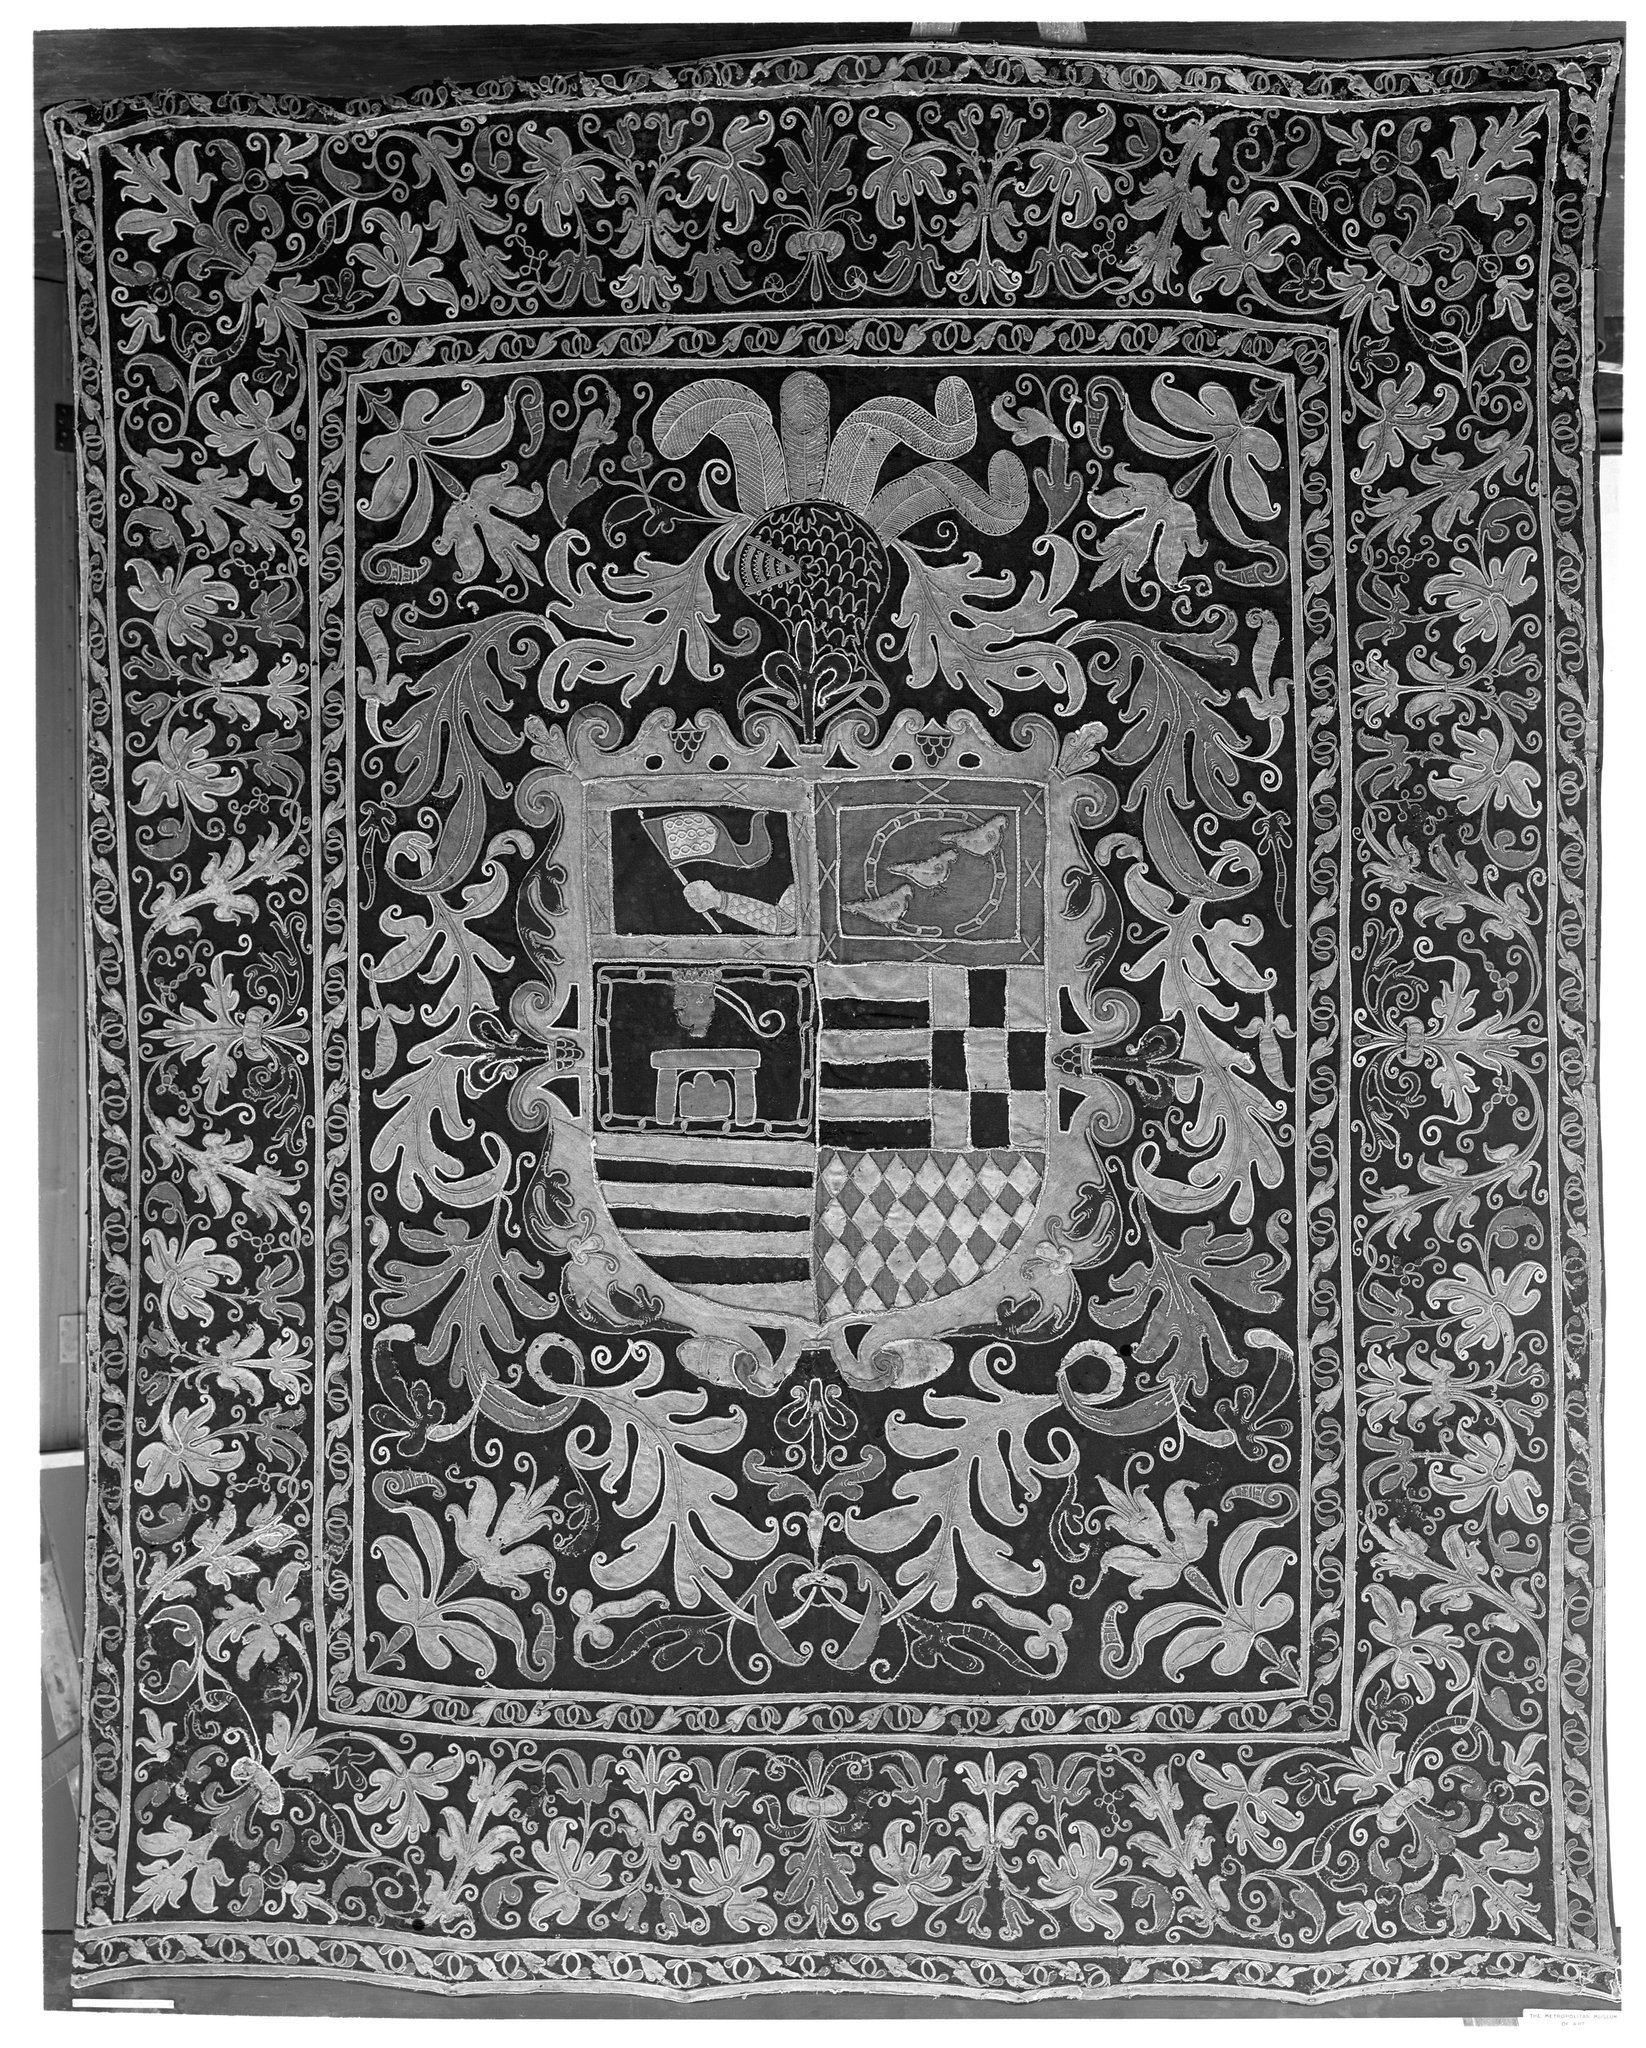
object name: hanging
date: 1567-1600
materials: linen, wool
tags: coat of arms